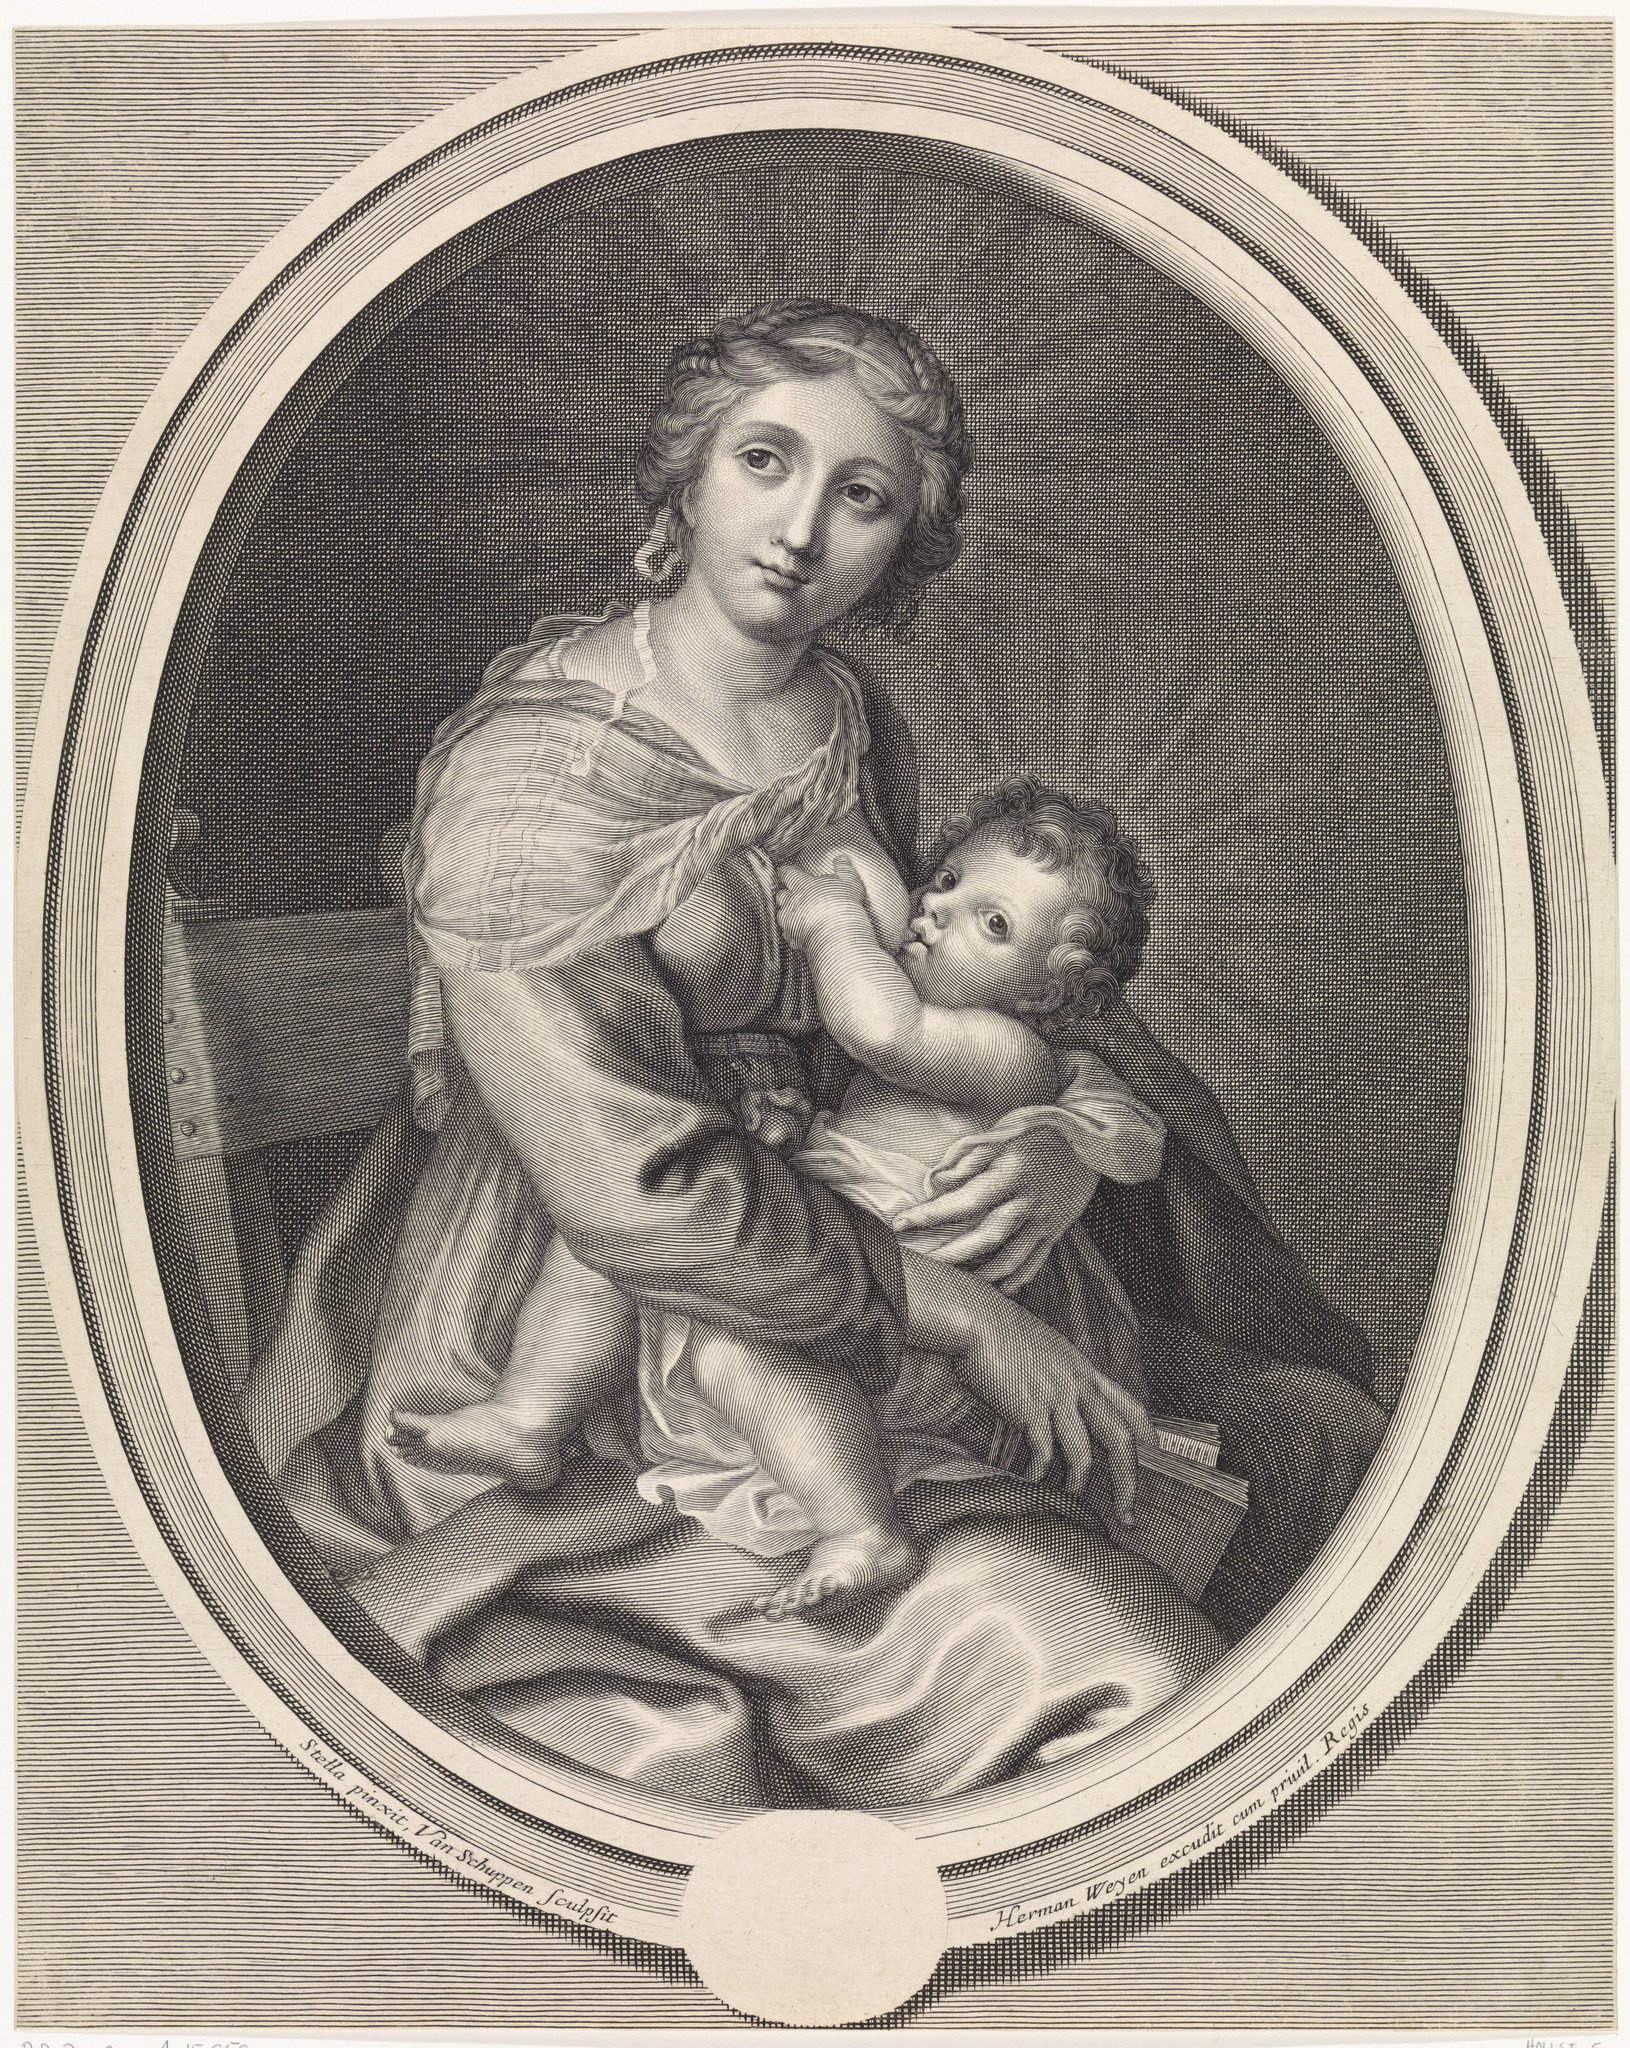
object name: print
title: Maria geeft het Christuskind de borst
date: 1655-1672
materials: paper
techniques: engraving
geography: paris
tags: christ-child suckling, or beginning to suckle, e.g. mary uncovering her breast ~ madonna-representations, book - mm - book open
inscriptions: collector's mark: Lugt 2228, inscription: ‘La Sainte vierge donnant le sein à l'enfant Jesus, d'après Stella. Sans les armes - belle Gr[avur]e’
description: Maria zit op een stoel en geeft het Christuskind de borst. In haar hand houdt zij een dichtgeslagen boek vast. Onderaan een wit gelaten ovaal.